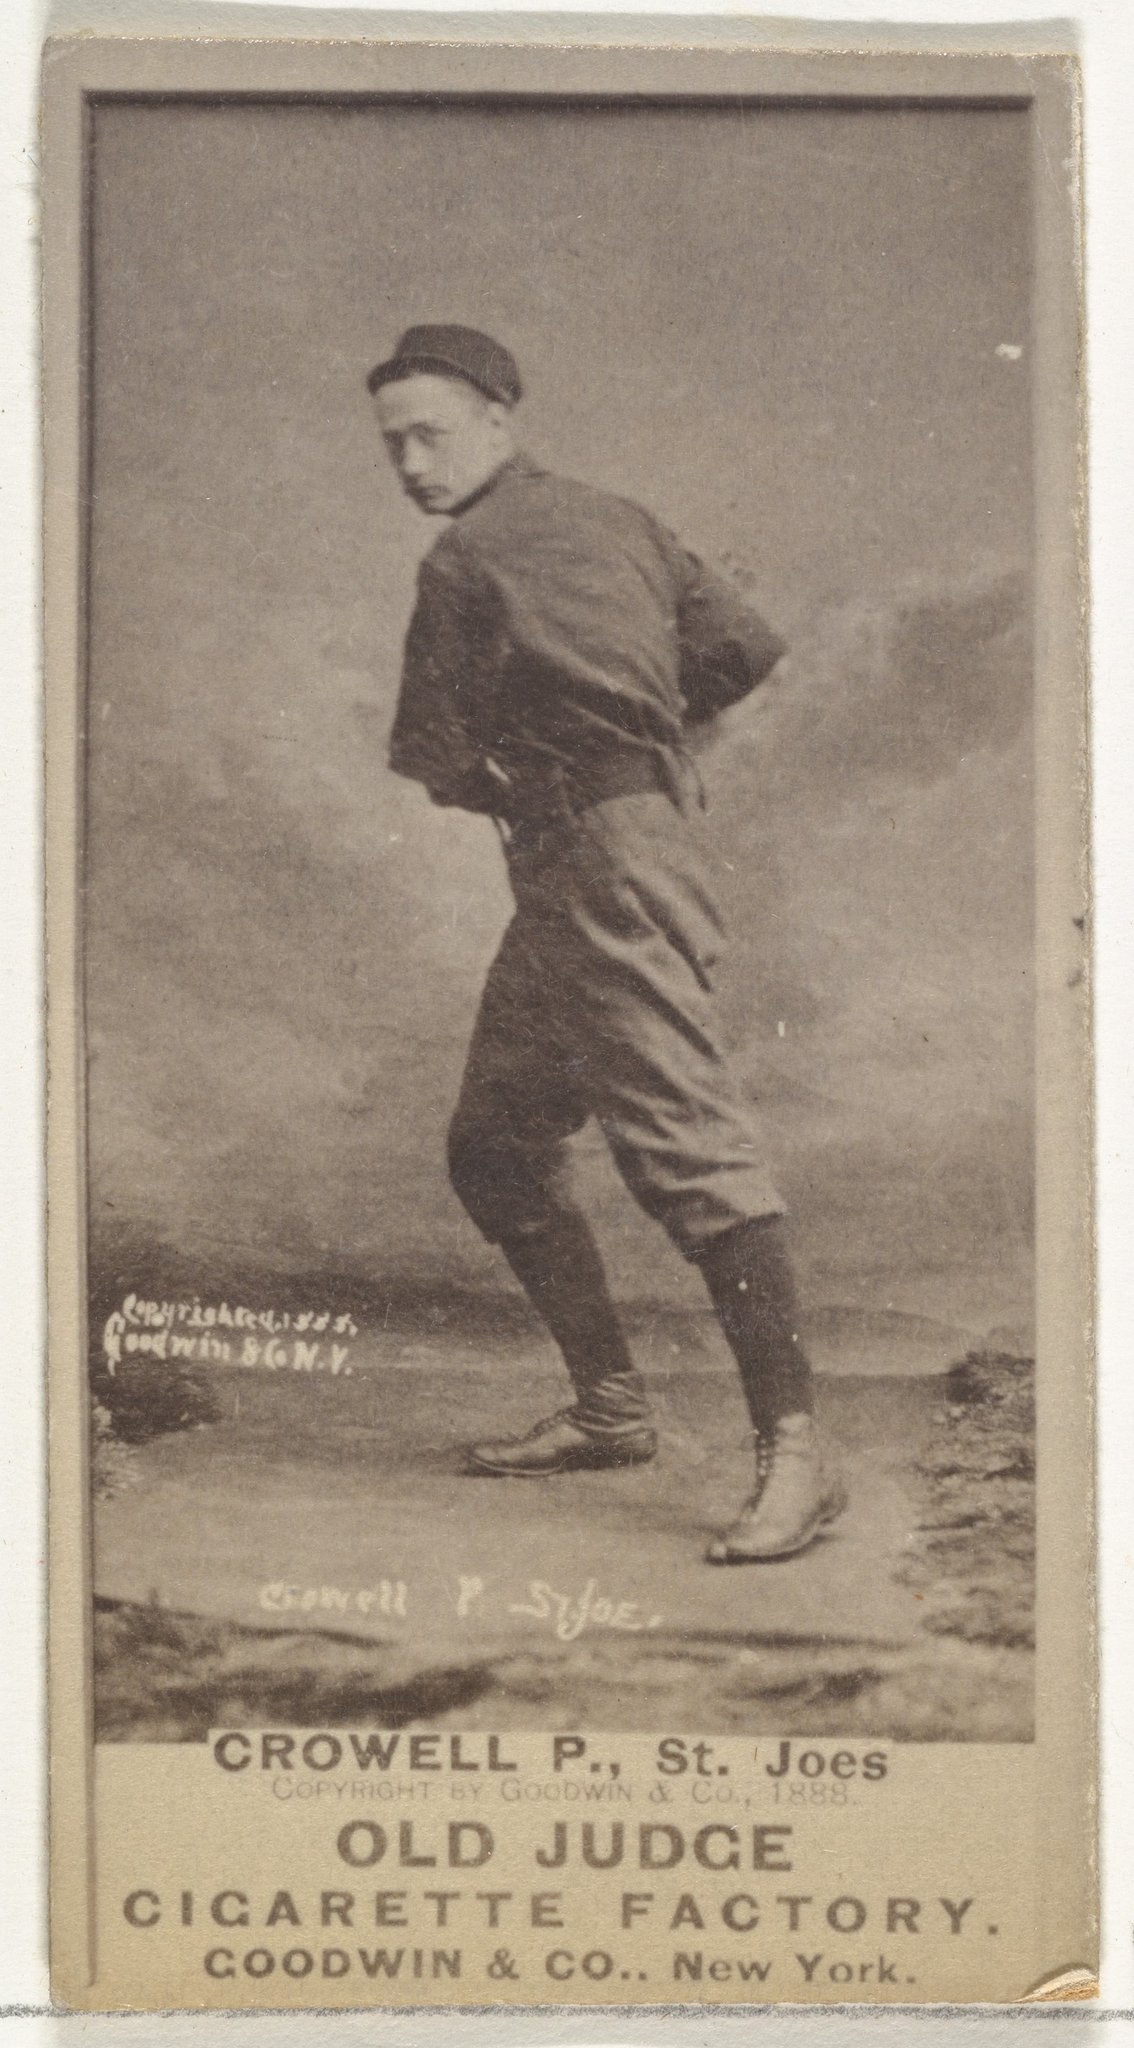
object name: baseball card, photograph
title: William Theodore "Billy" Crowell, Pitcher, St. Joseph Clay Eaters, from the Old Judge series (N172) for Old Judge Cigarettes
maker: goodwin & company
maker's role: publisher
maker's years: 1850-1950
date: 1888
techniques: albumen silver print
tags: men,portraits,baseball,athletes